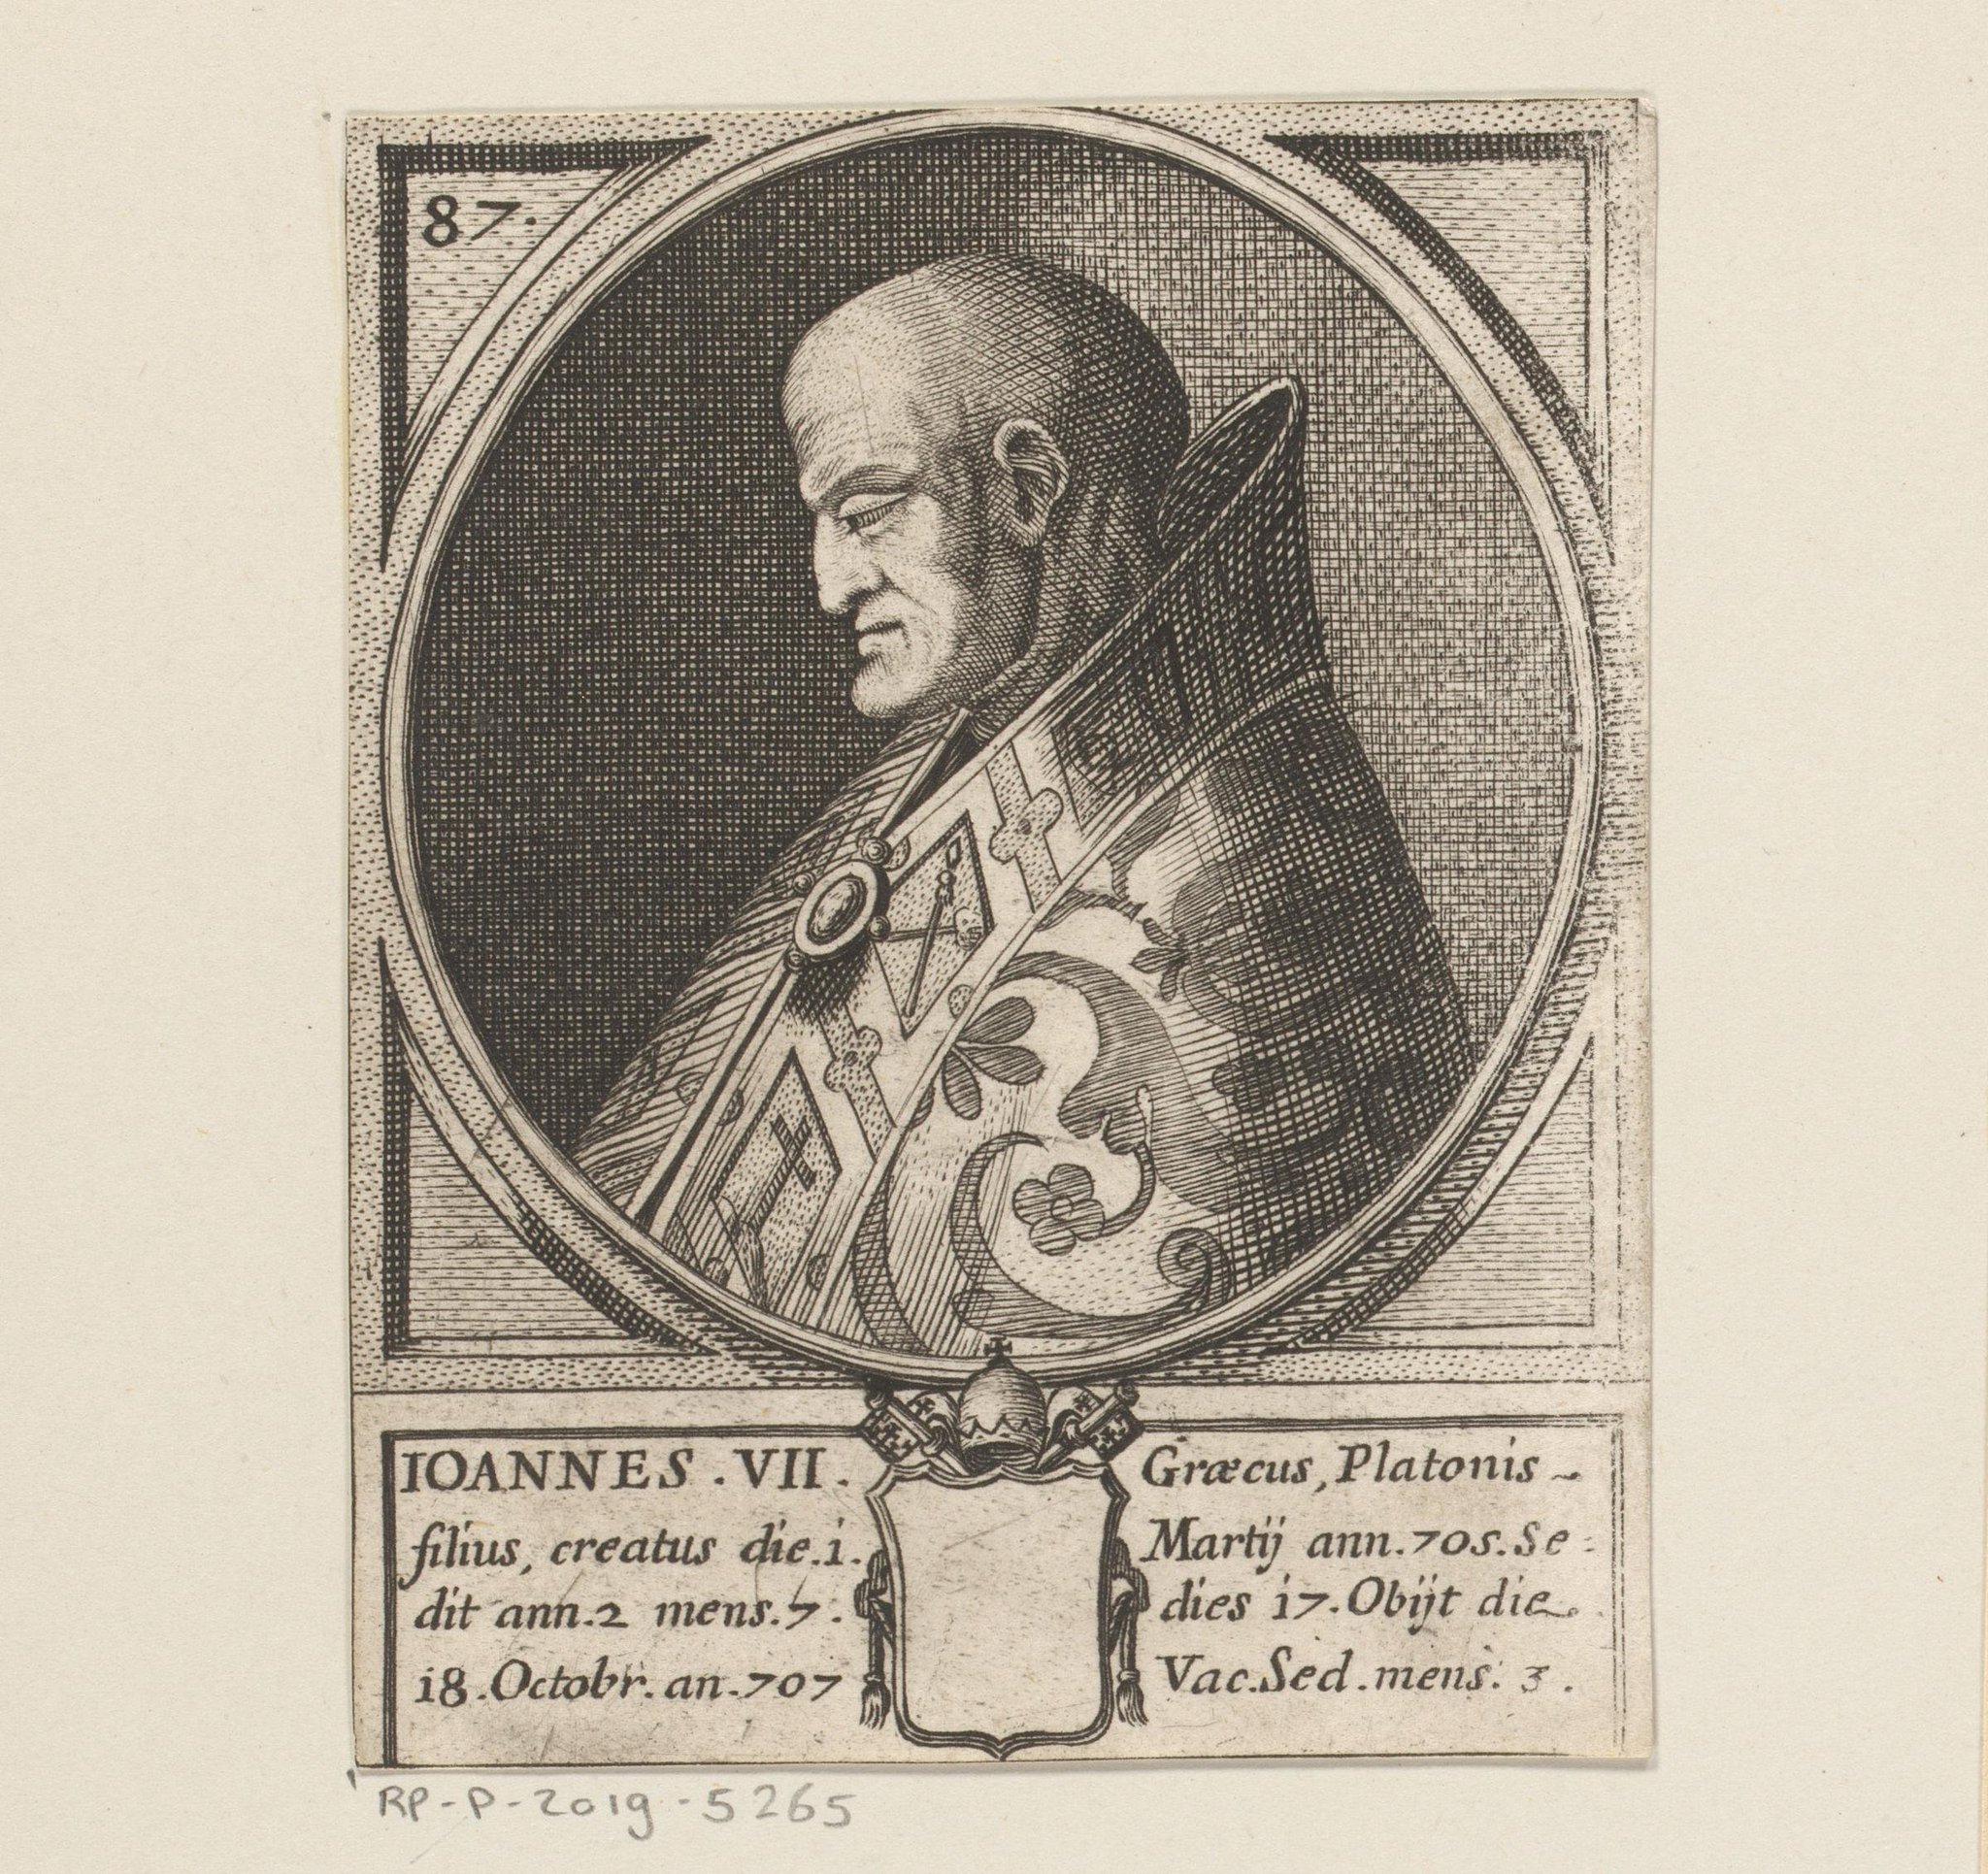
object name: print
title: Chronologia summorum Romanorum pontificum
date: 1675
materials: paper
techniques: engraving, etching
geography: rome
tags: historical persons, pope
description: Portret afkomstig uit een grote prent, bestaande uit 17 bladen die samengevoegd konden worden, uitgegeven door Giovanni Giacomo de' Rossi in 1675.